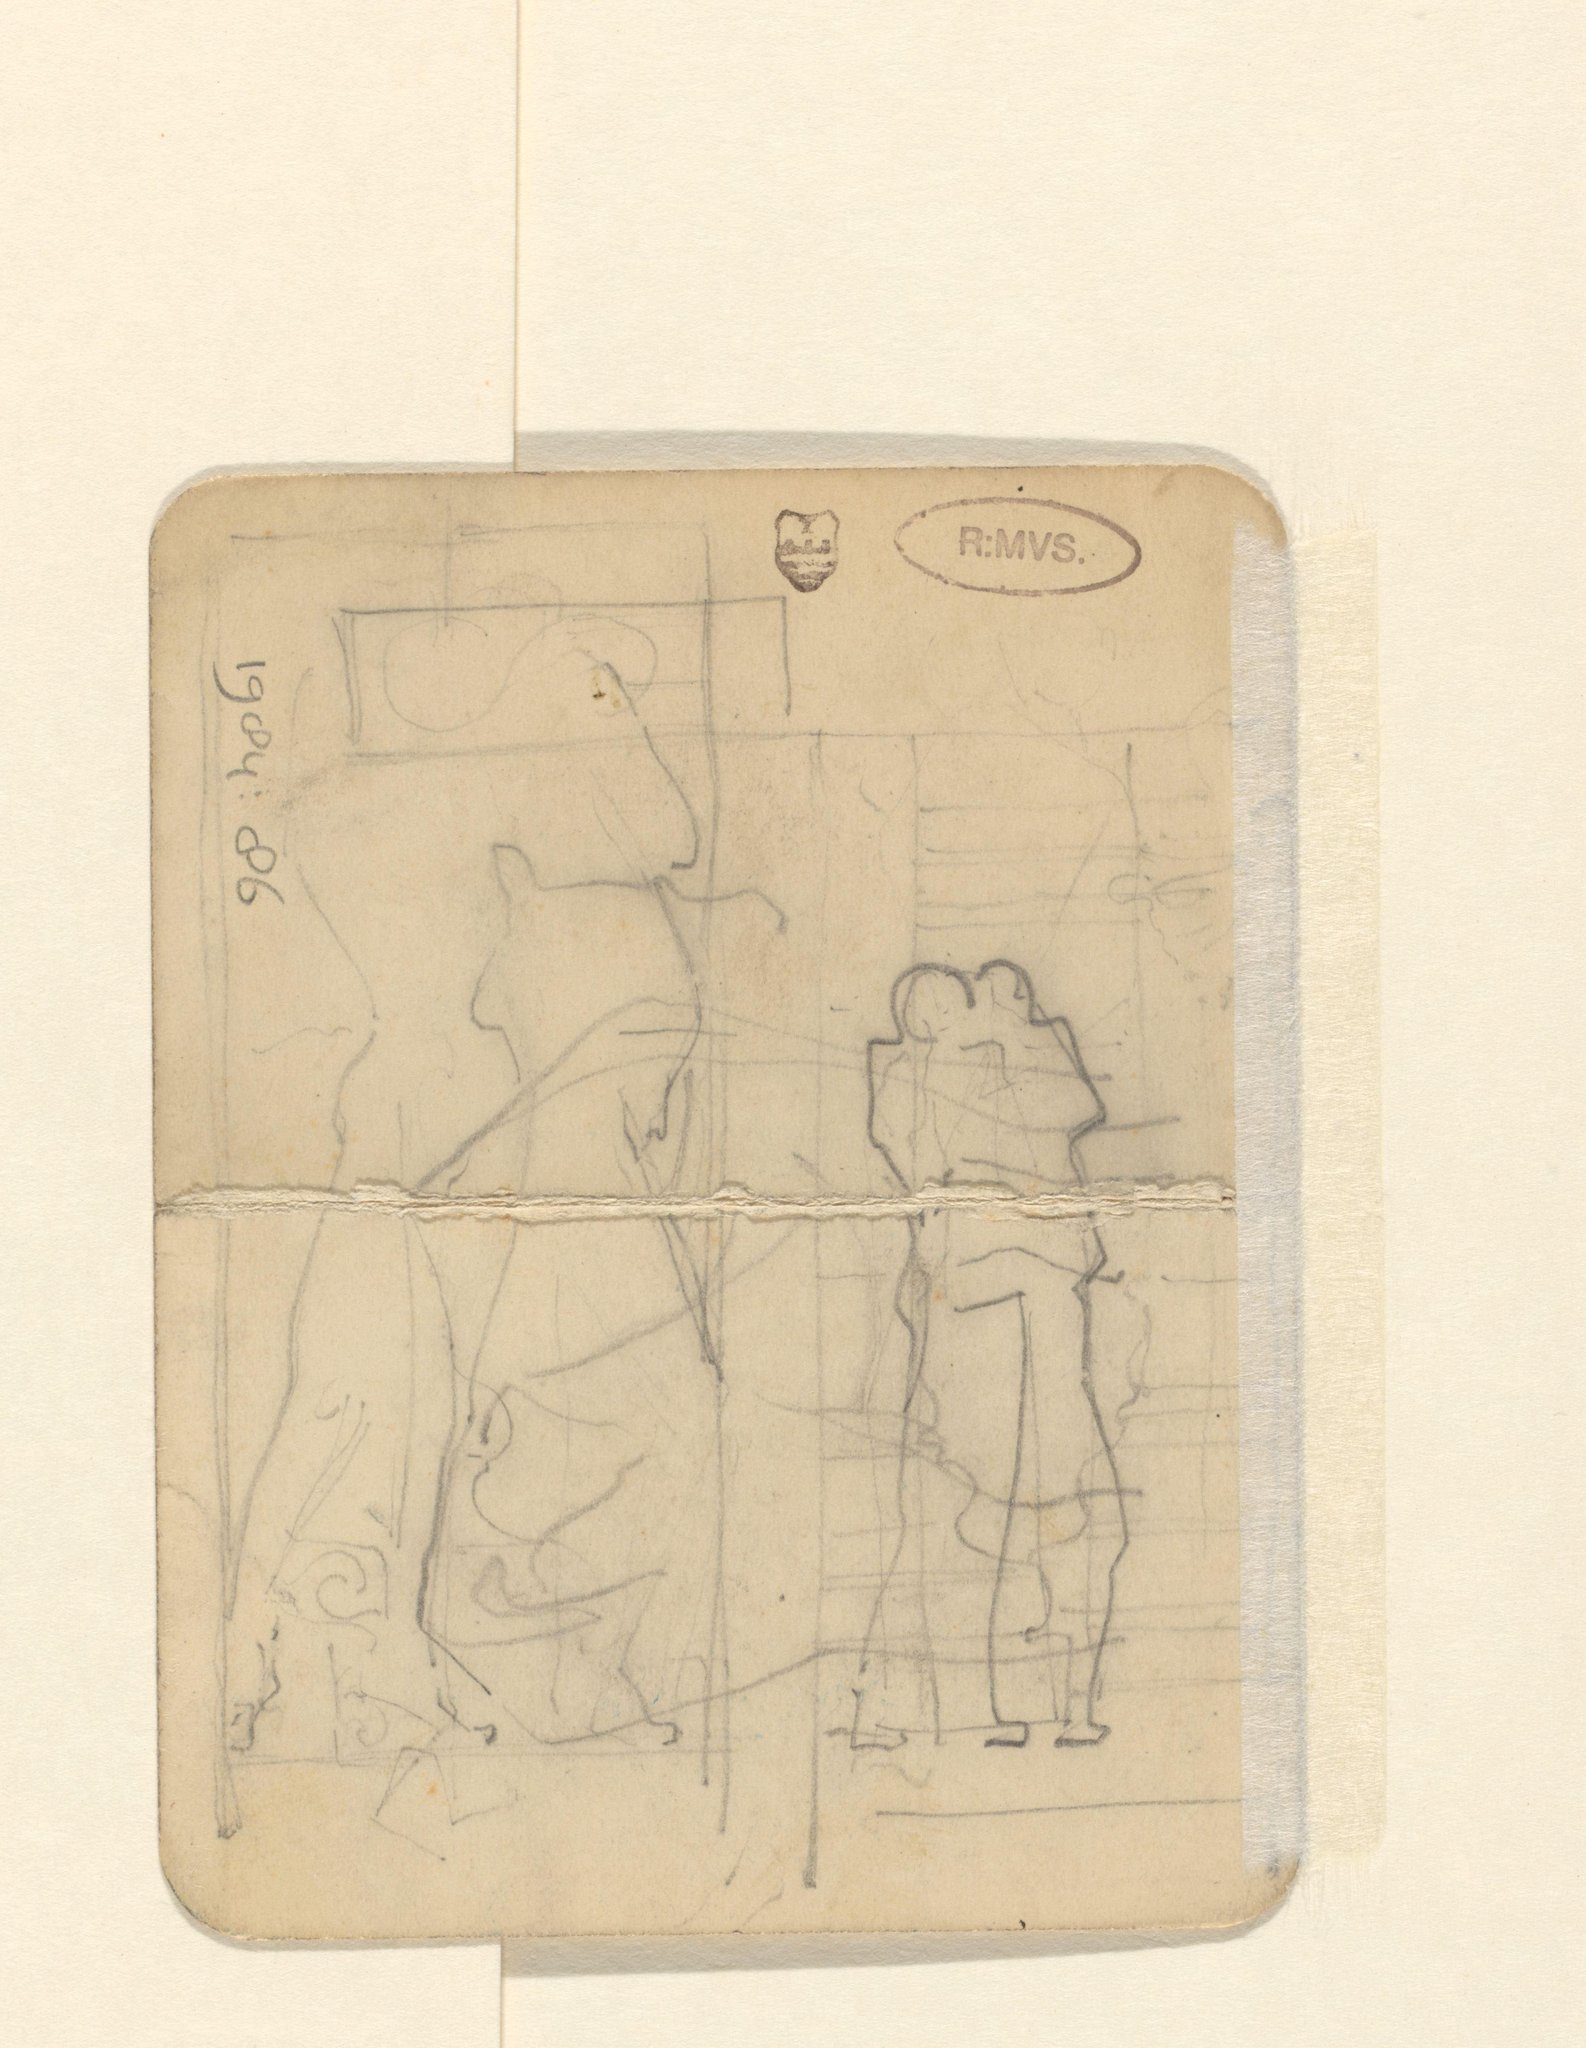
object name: drawing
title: Twee figuren die elkaar omarmen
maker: reijer stolk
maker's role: draughtsman, print maker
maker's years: 1896-1945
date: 1906-1945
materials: paper, pencil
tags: (lovers) embracing each other, 'symplegma', standing figure - aa - female human figure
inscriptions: collector's mark: Lugt 2228, collector's mark: Lugt 2760